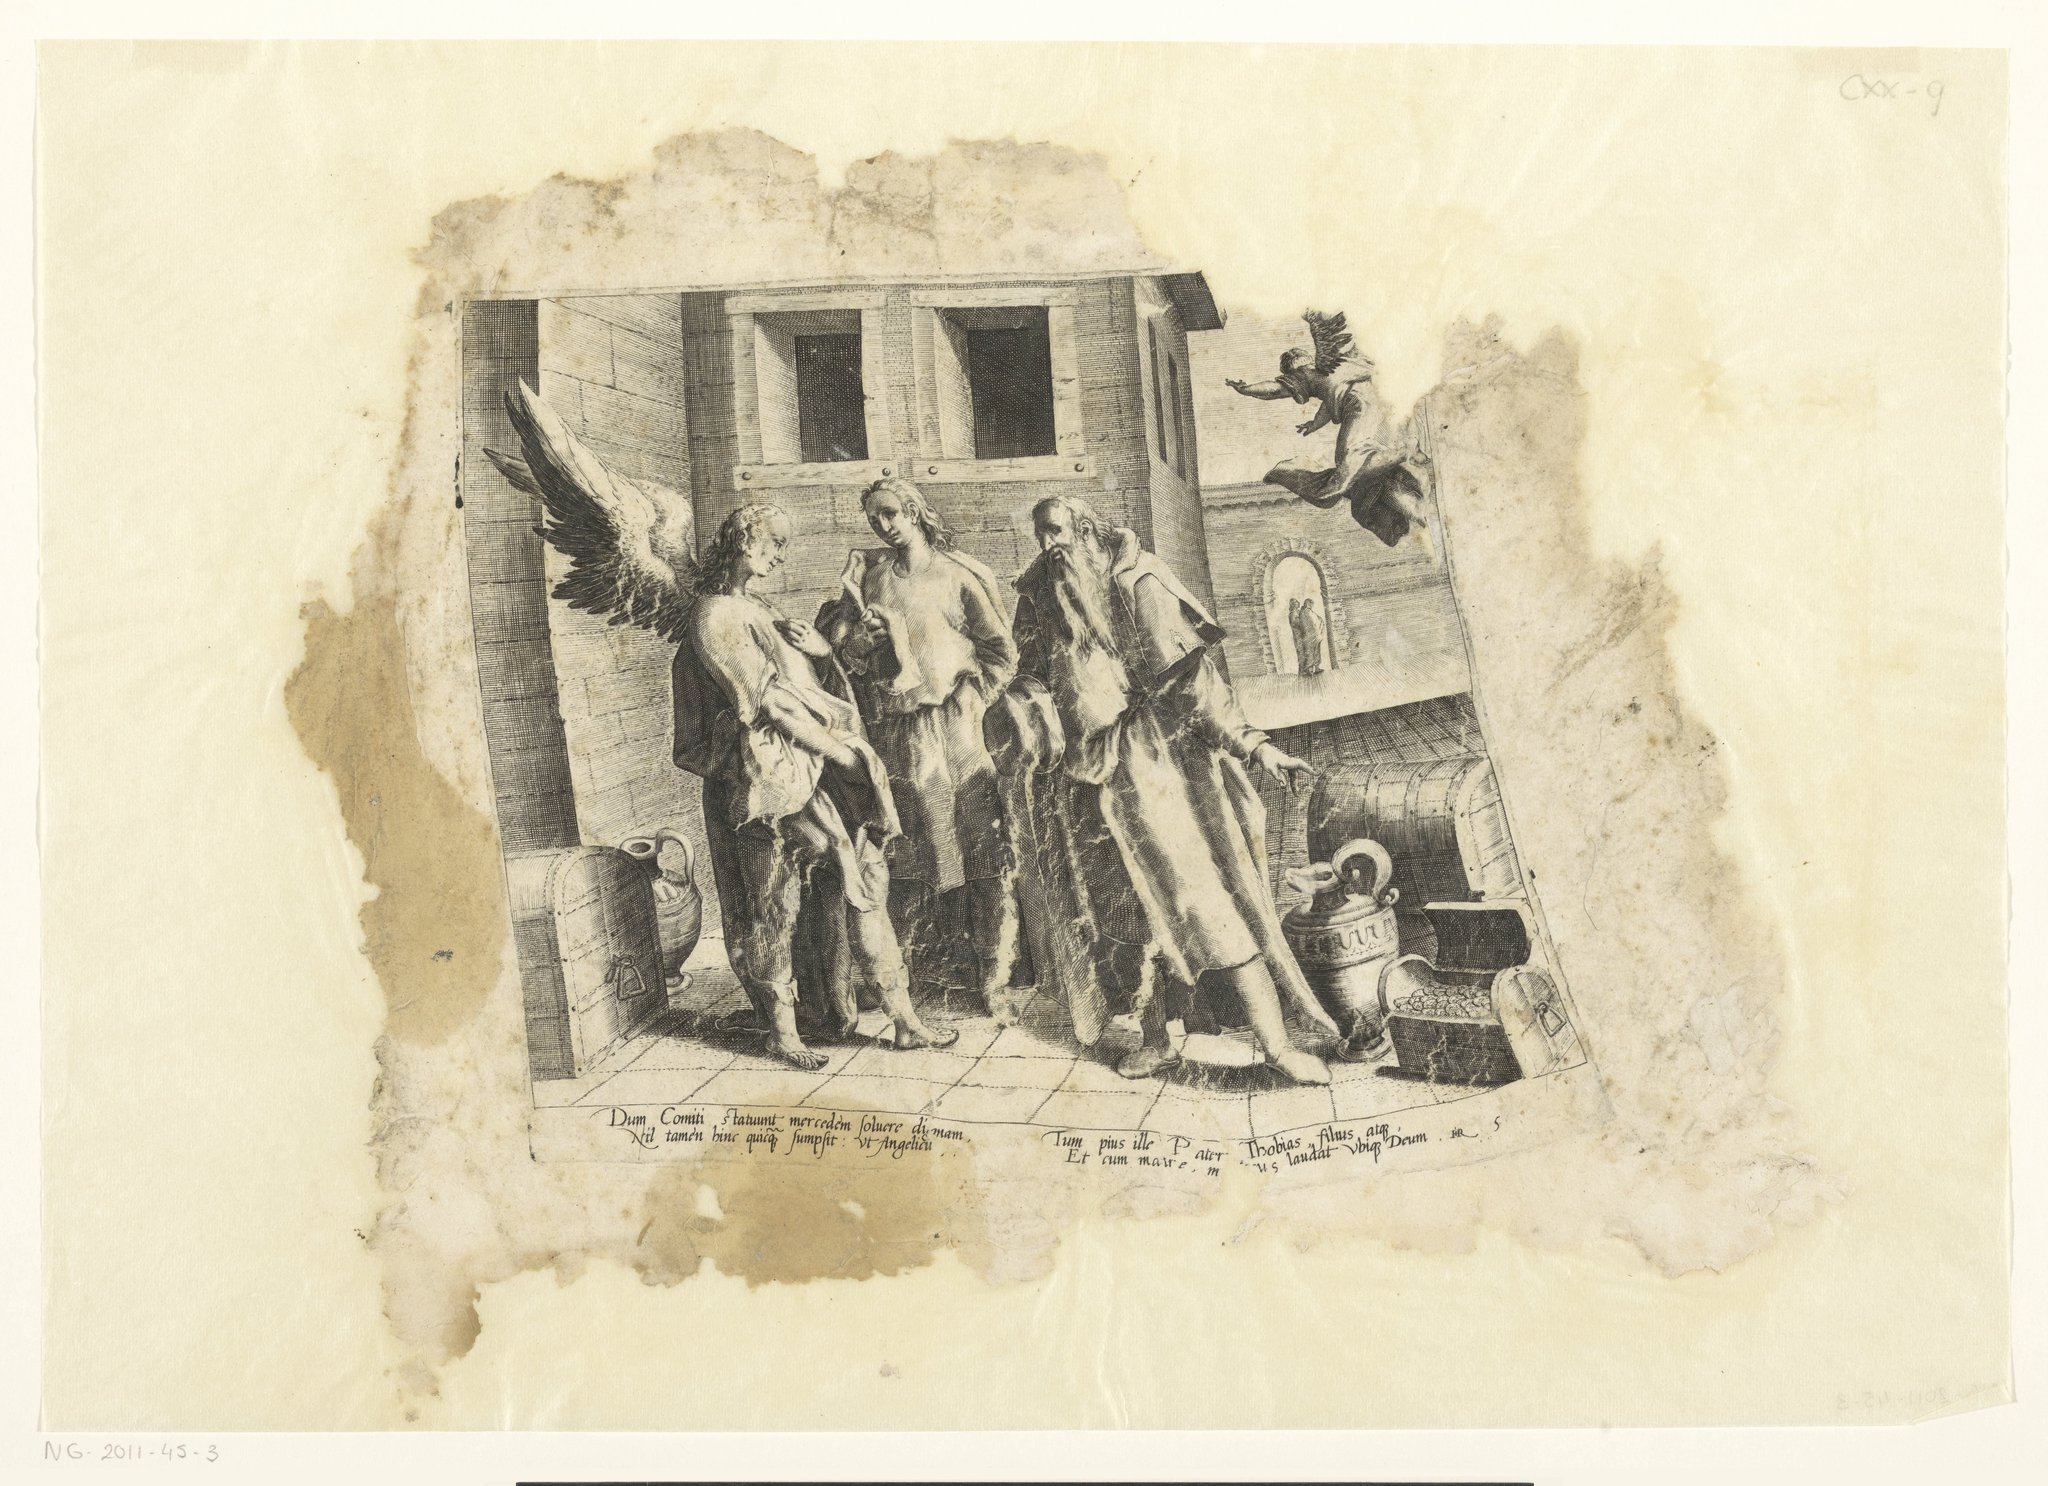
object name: print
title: Geschiedenis van Tobias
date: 1580-1596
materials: paper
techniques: engraving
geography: amsterdam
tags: tobias and his father offer gifts to the angel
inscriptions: watermark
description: De prenten in de Nova Zembla collectie zijn tijdens een expeditie van Willem Barendsz en Jacob van Heemskerk in 1596-1597 noodgedwongen in het winterkamp, het ‘Behouden Huis’, op het eiland achtergelaten. De prenten waren in één of meerdere stapels als handelswaar meegenomen vanuit Amsterdam. Bijna drie eeuwen later, in 1871, keerde de Noor Elling Carlsen terug naar Nova Zembla en vond daar de restanten van het ‘Behouden Huis, inclusief een groot deel van de inventaris. Een deel van de prenten, in de vorm van aaneengekoekte kluiten, werd toen ook teruggevonden. De papierkluiten waren soms op meerdere plekken gebroken. Tussen 1975-1979 zijn de prenten van elkaar gescheiden. Dit leverde in totaal ca. 1000 fragmenten van ca. 400 afdrukken van ca. 150 verschillende prenten op. Voor zover mogelijk zijn de fragmenten samengevoegd en zijn de prenten gereconstrueerd.